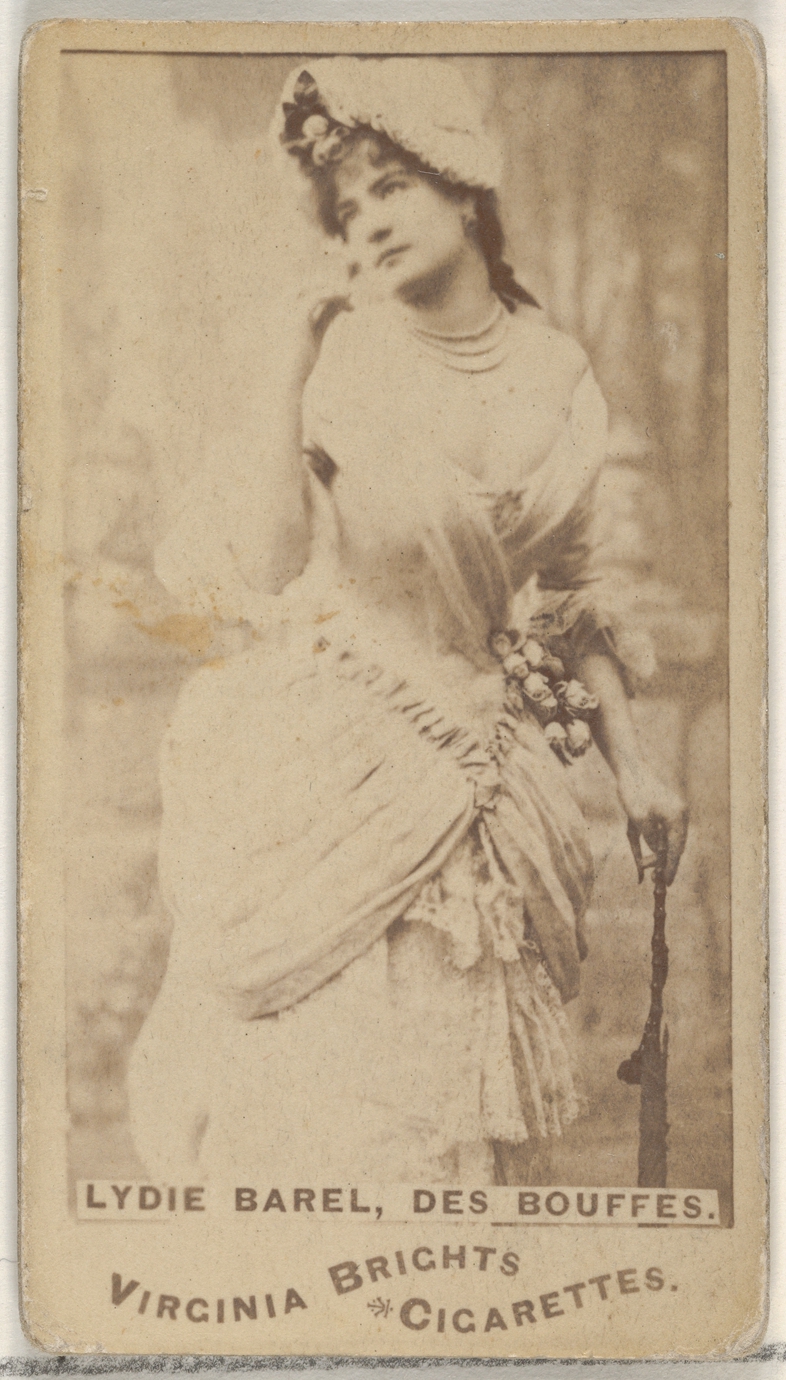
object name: photograph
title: Lydie Barel, Des Bouffes, from the Actors and Actresses series (N45, Type 1) for Virginia Brights Cigarettes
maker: allen & ginter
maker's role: publisher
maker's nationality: american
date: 1888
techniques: albumen silver print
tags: portraits,women,actresses